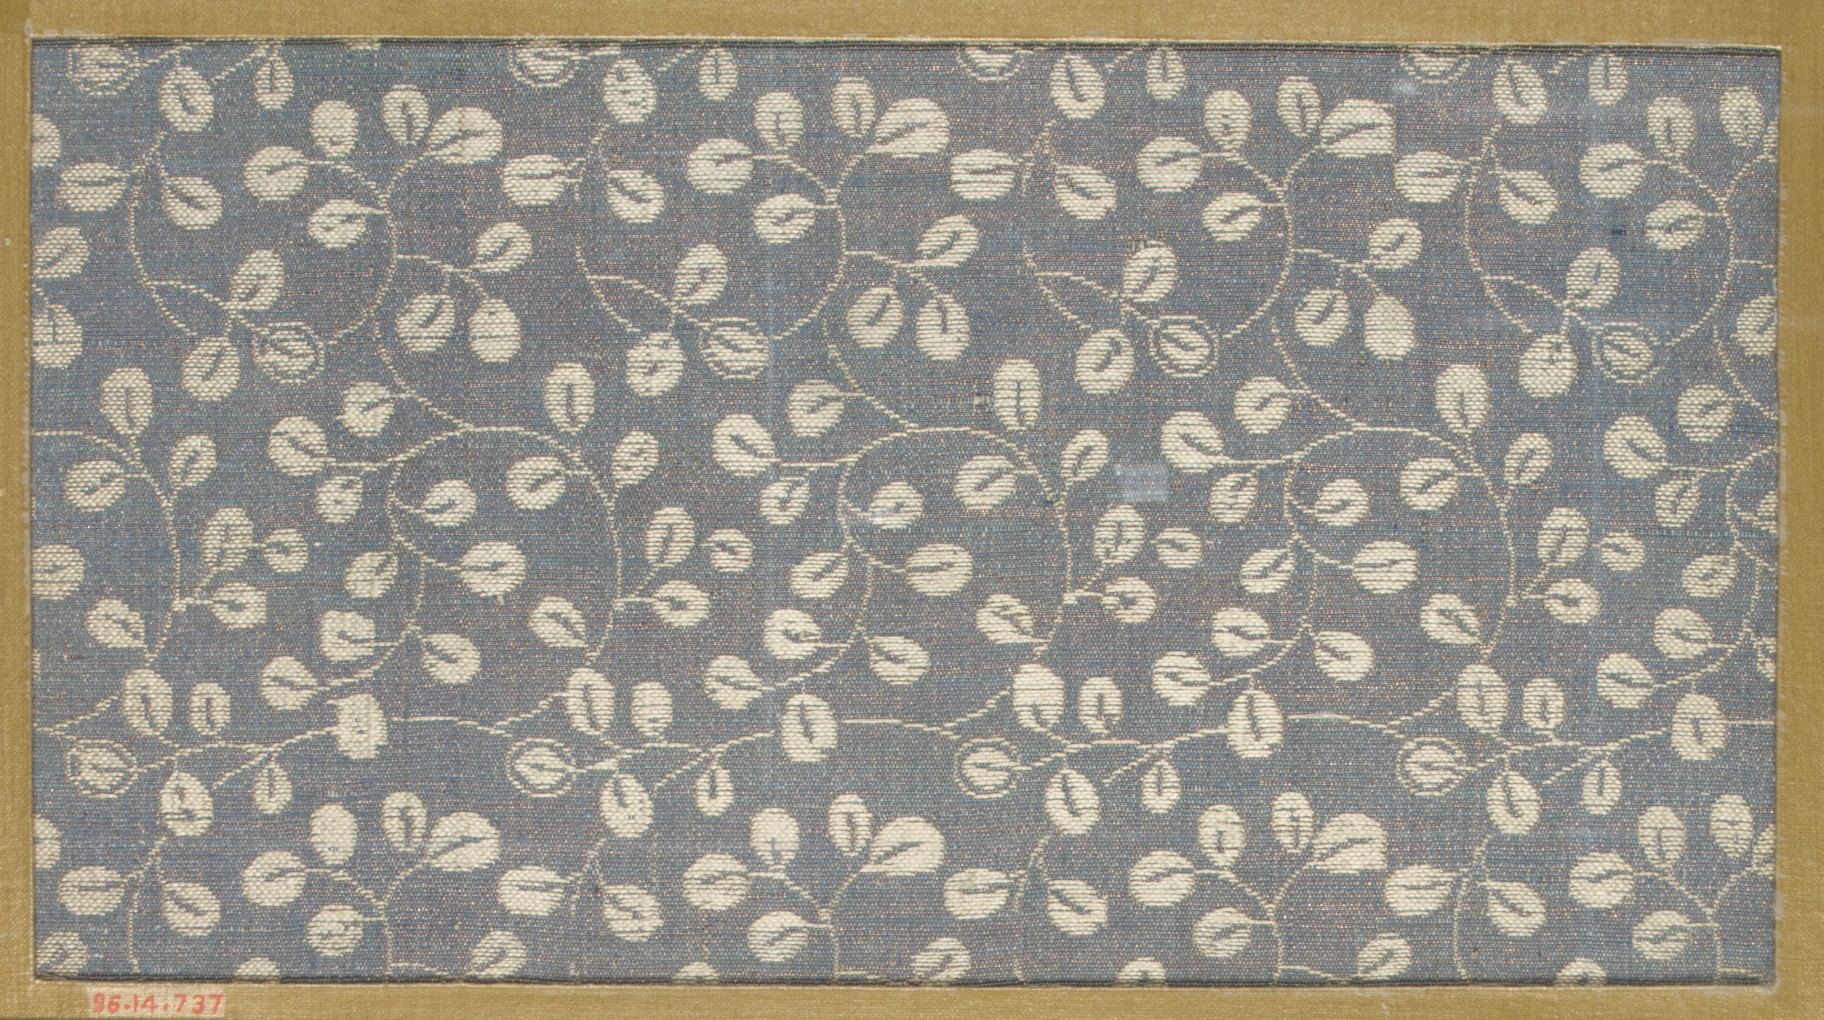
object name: piece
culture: japanese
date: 1701-1900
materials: silk